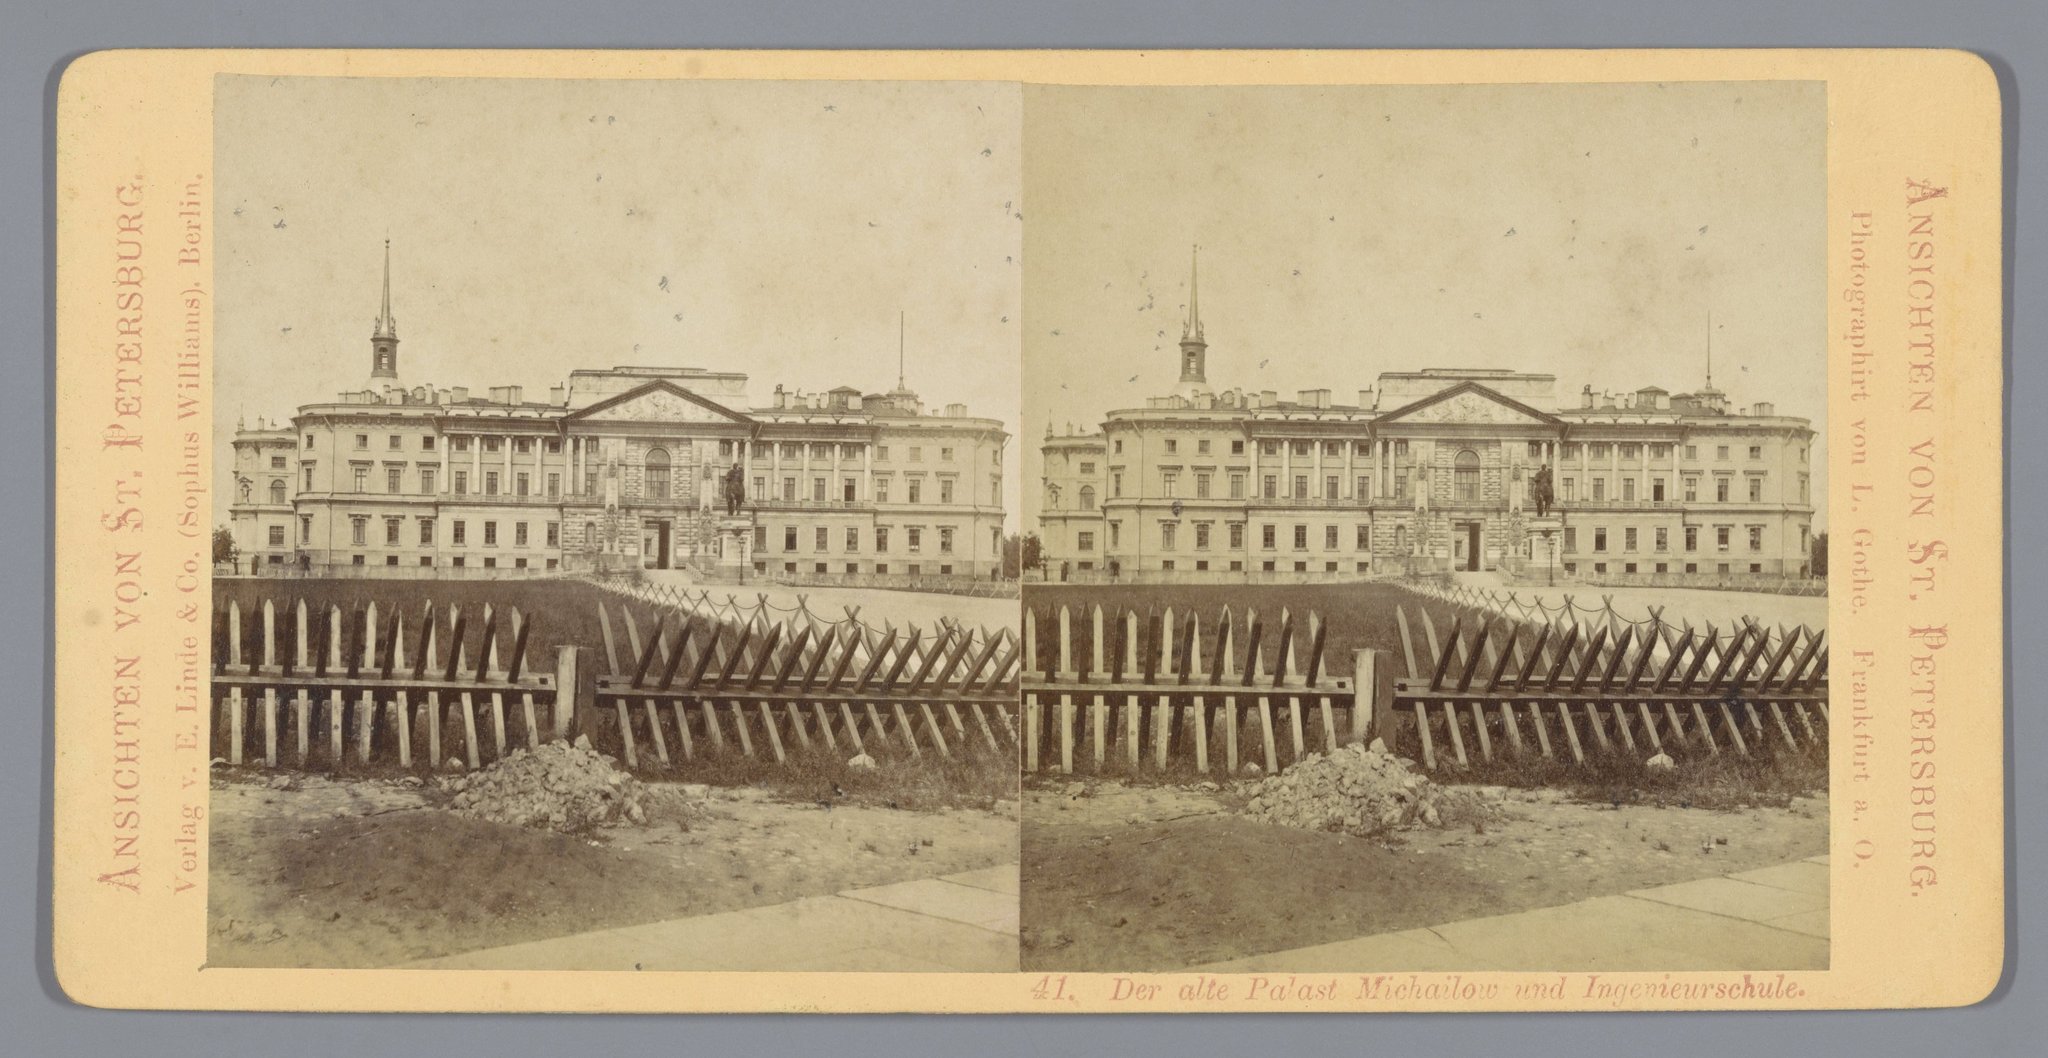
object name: stereograph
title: Gezicht op het Mikhailovskipaleis (nu het Russisch Museum) in Sint-Petersburg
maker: louis gothe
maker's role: fotograaf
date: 1850-1880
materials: cardboard, photographic support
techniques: albumen print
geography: sint-petersburg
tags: fence, wall, paling, palace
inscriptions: inscription: ‘Ansichten von St. Petersburg.’, number: ‘41.’